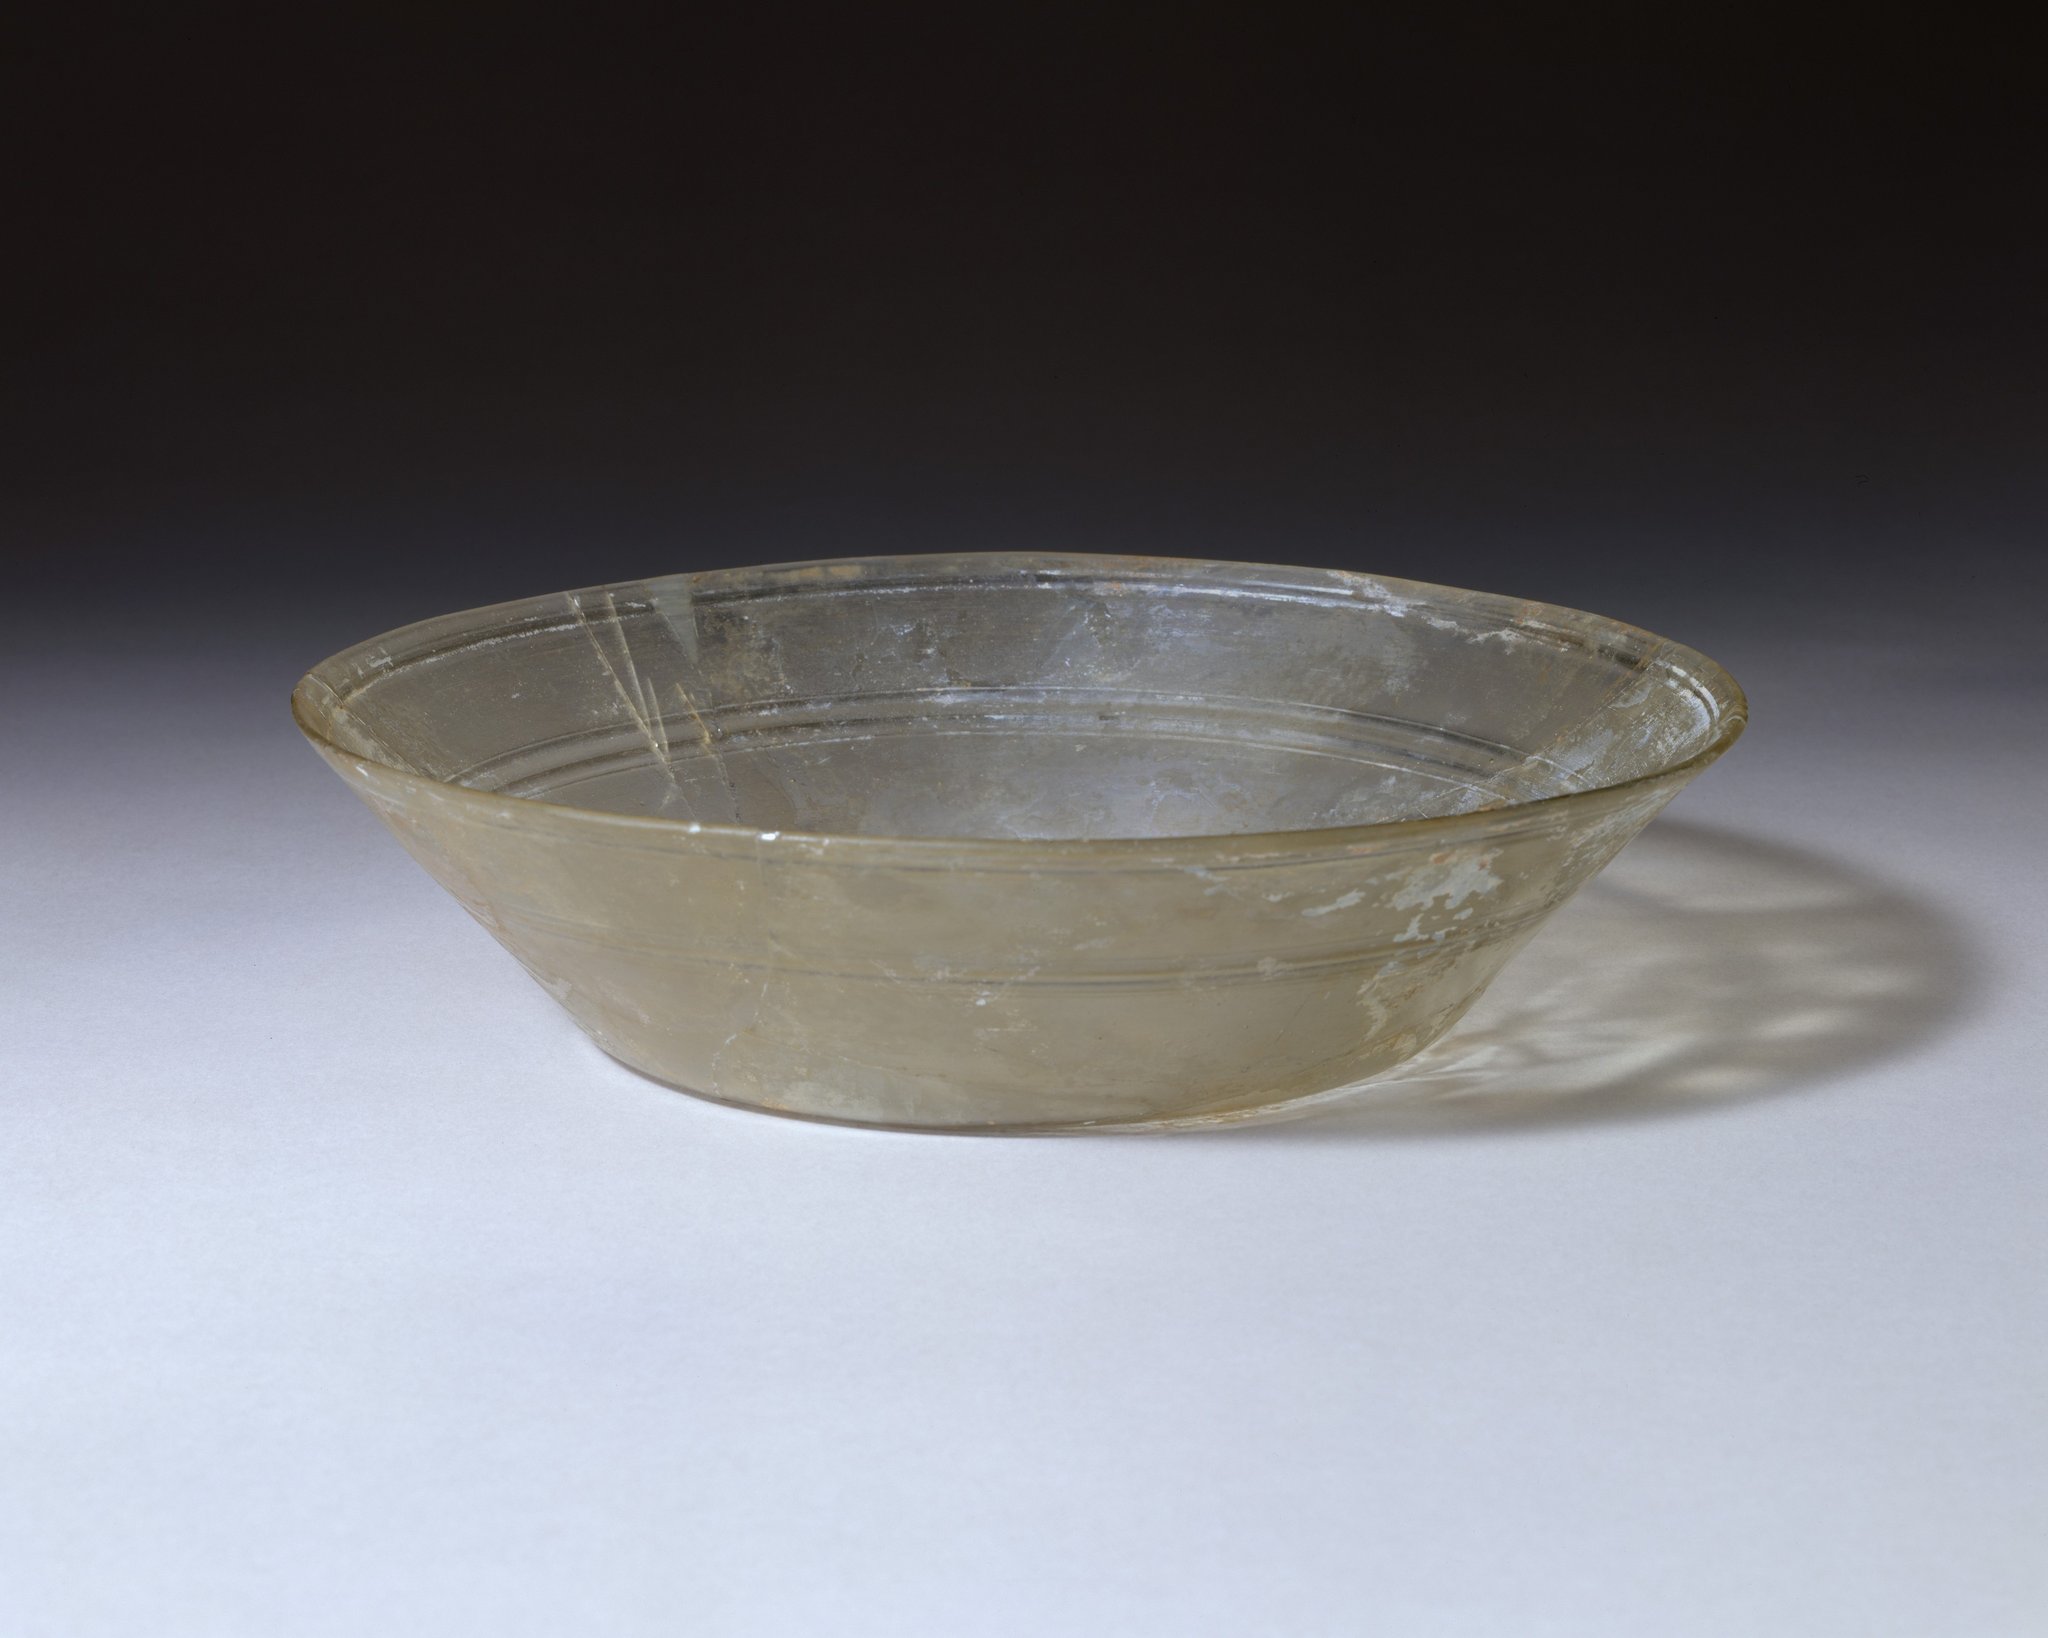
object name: dish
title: Glass dish with gilding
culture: greek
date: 200-101 BCE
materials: glass